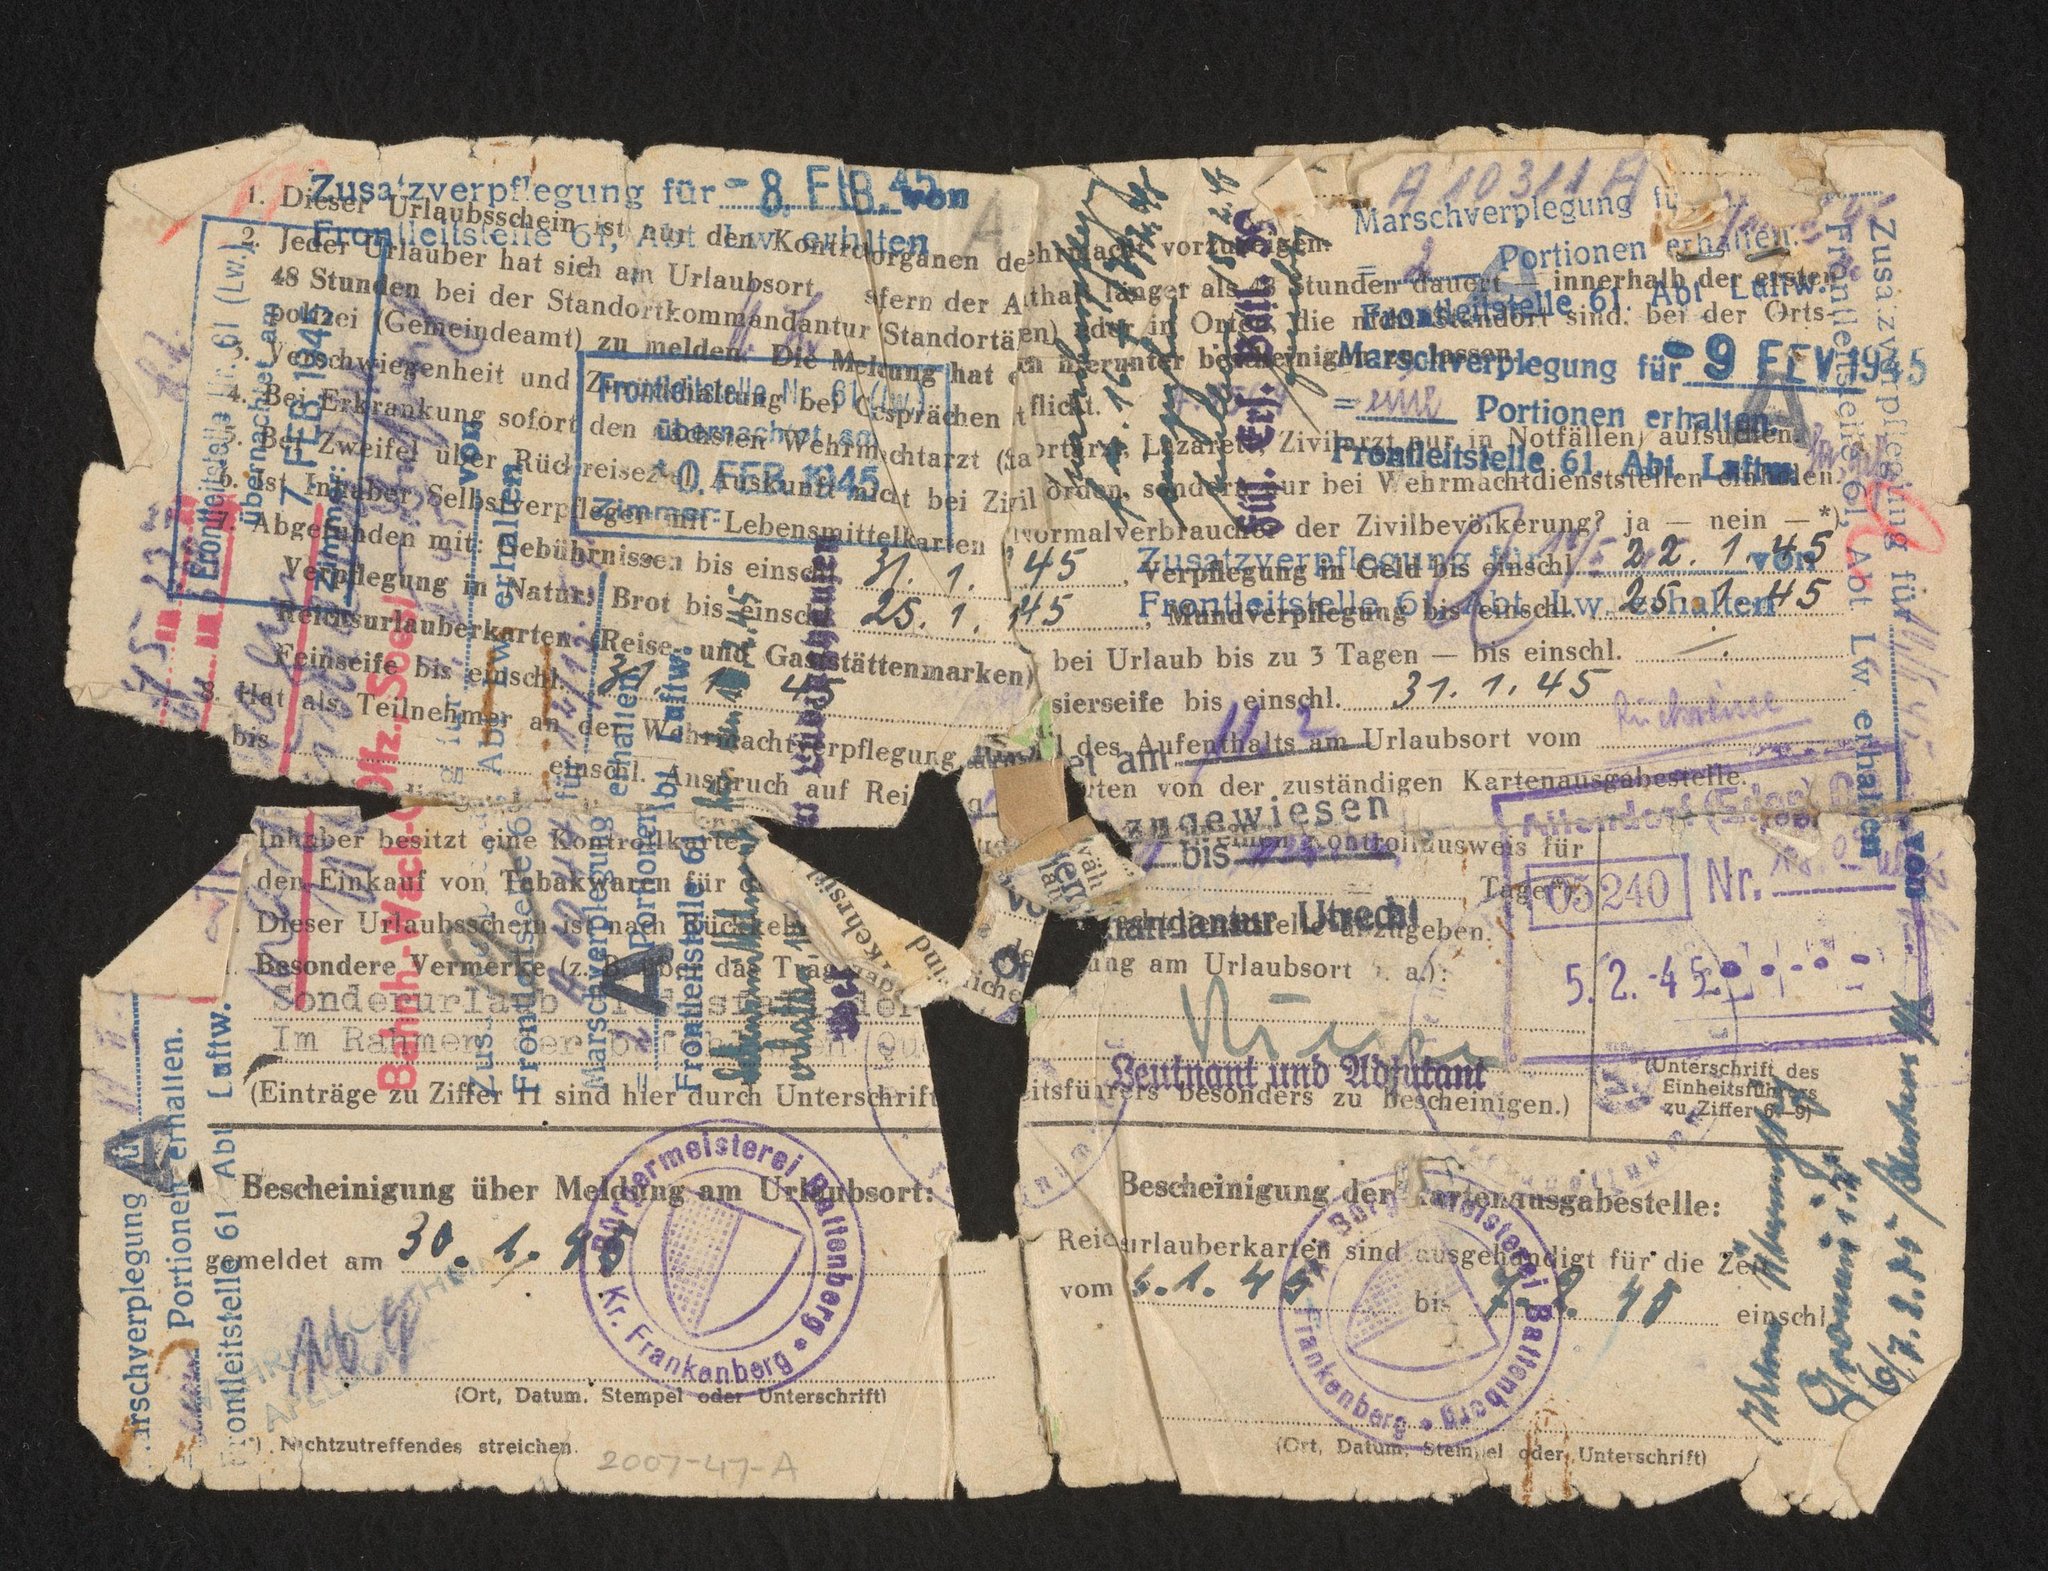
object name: document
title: Kriegsurlaubsschein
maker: Anonymous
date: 1945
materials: paper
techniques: printed materials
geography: germany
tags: the soldier; the soldier's life, occupation ~ war, netherlands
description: Persoonlijke reisdocument met twee aangehechte supplementen van Hans Heineman, gedateerd 23 januari 1945. Document in melinexmapje los in de doos bij het fotoalbum 'Kriegszeit in Holland' over de diensttijd in Nederland van Hans Heinemann van een Flak Regiment van de Luftverteidigungskommando van de Luftwaffe.